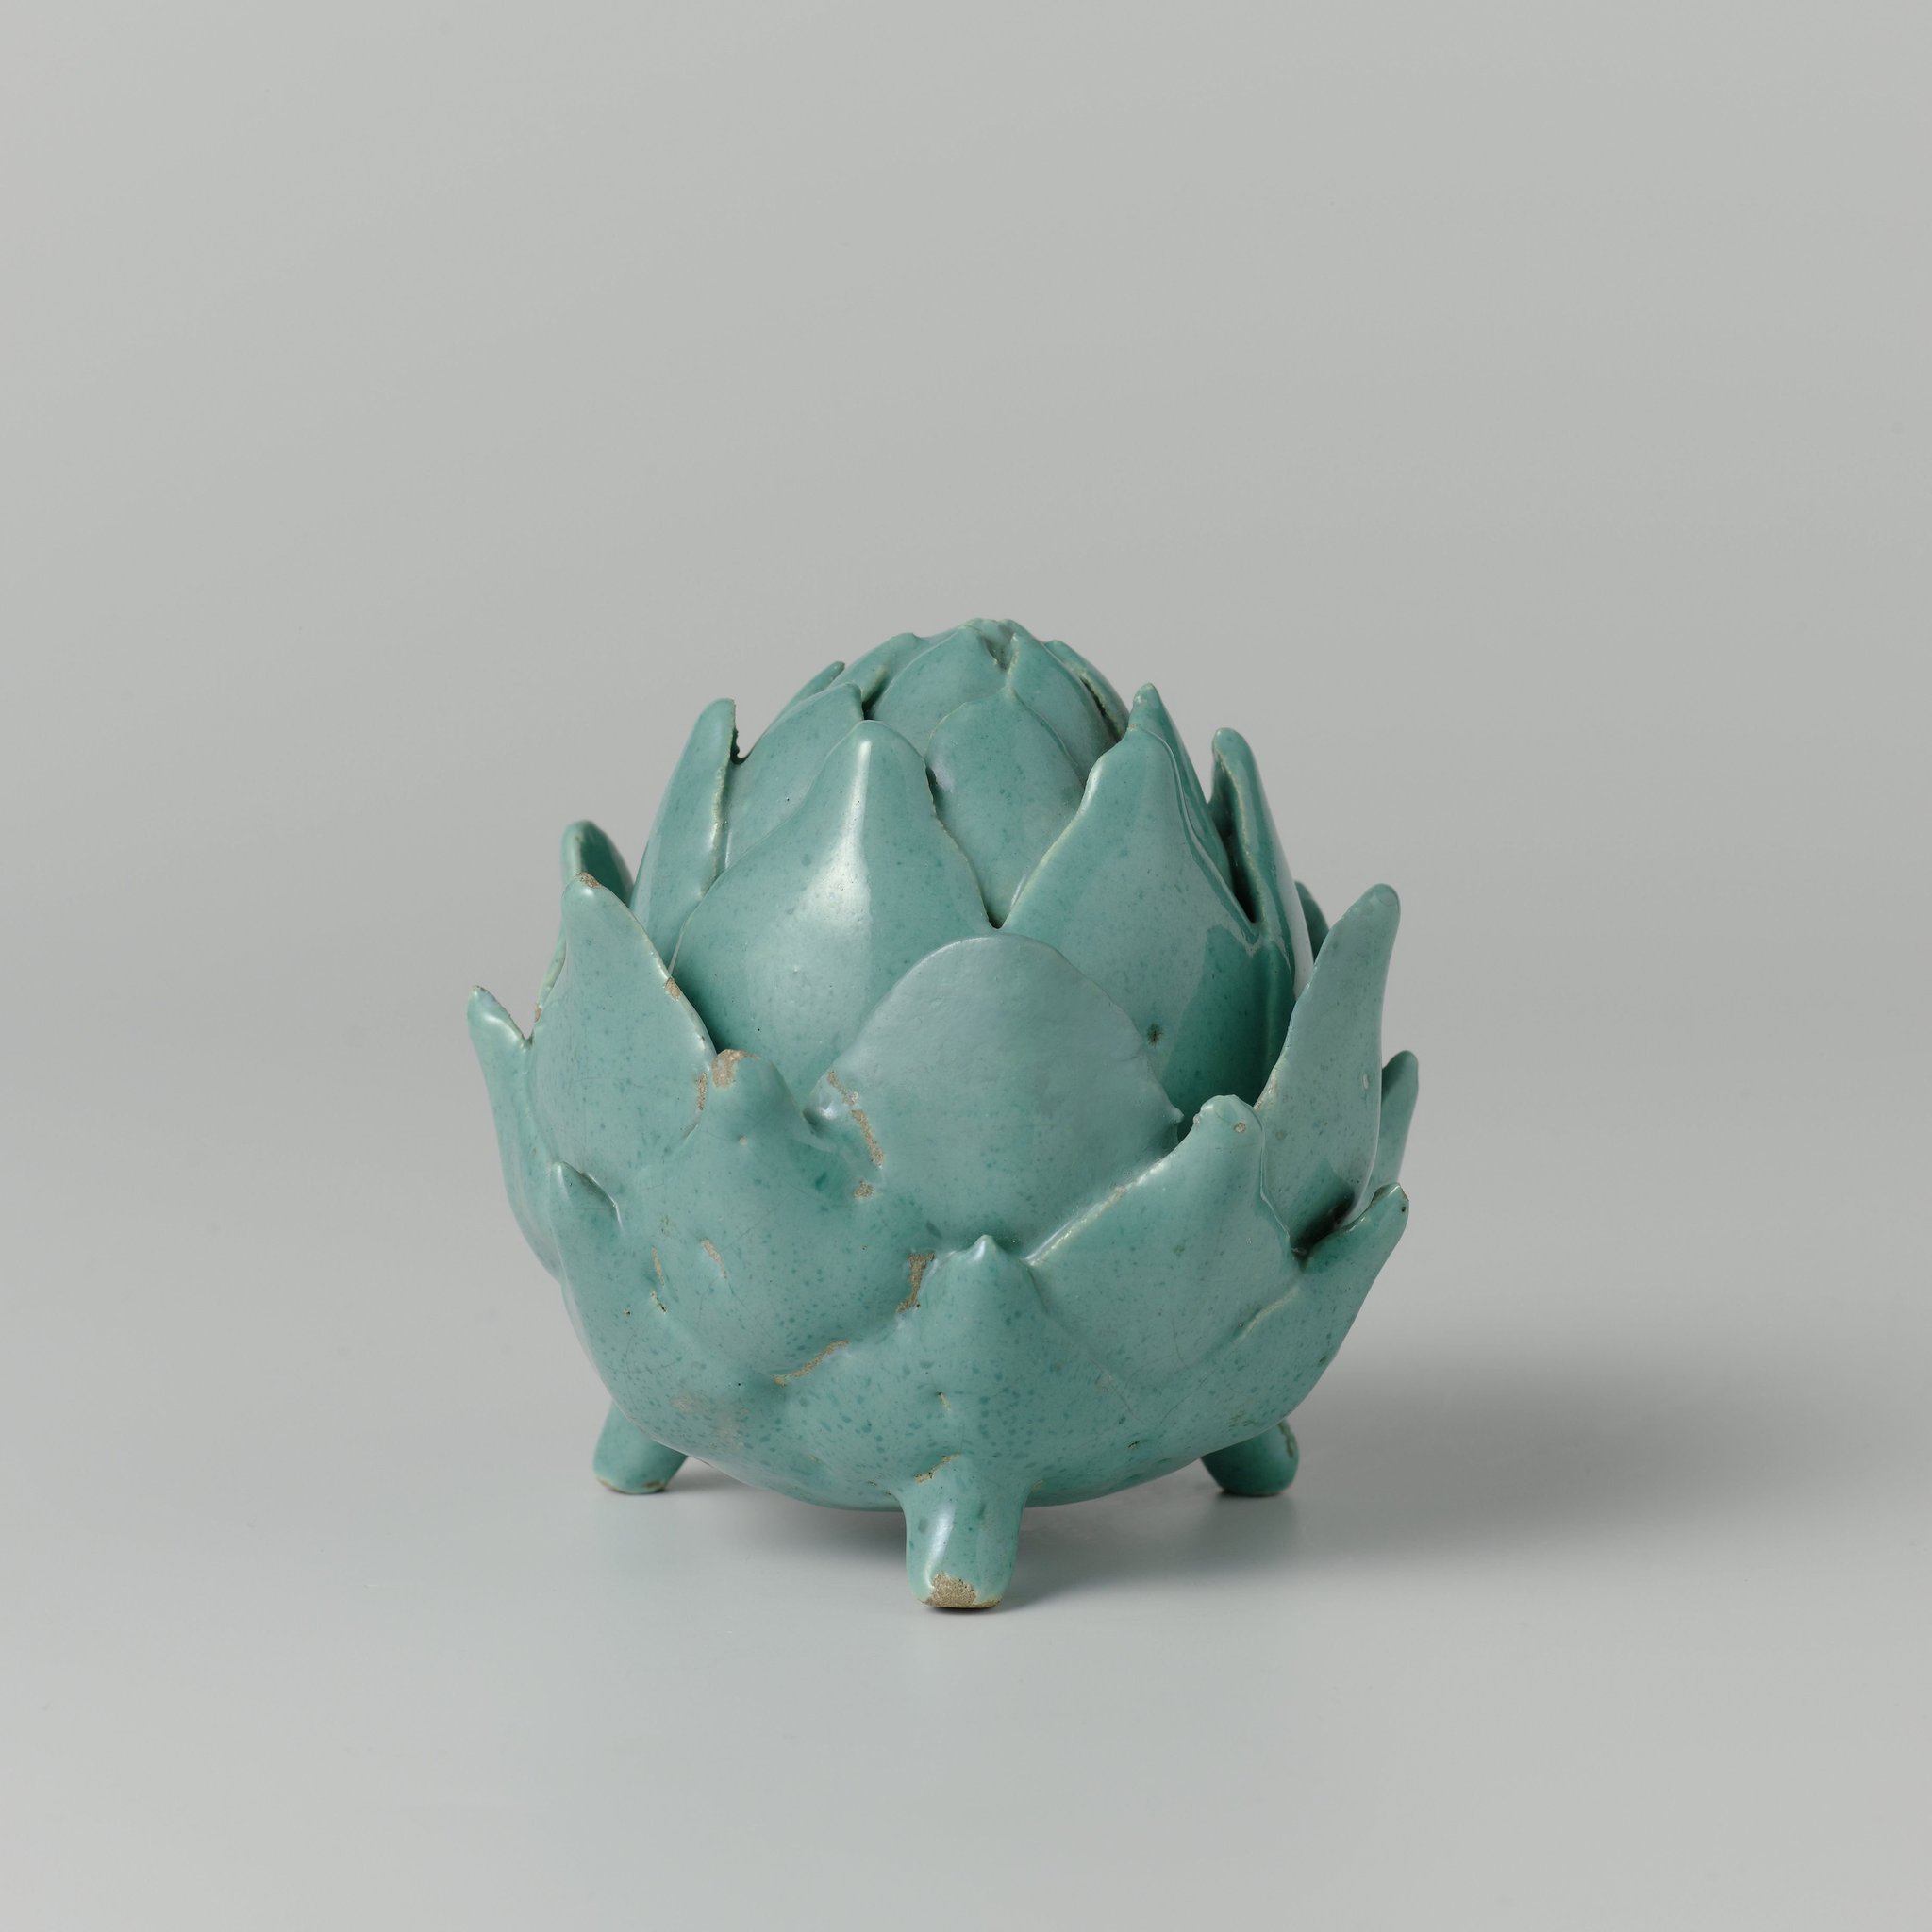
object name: butter dish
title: Botervloot van faience in de vorm van een artisjok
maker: Anonymous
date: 1740-1775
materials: earthenware, glaze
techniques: painted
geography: delft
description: Botervloot van groen gekleurde faience in de vorm van een artisjok.